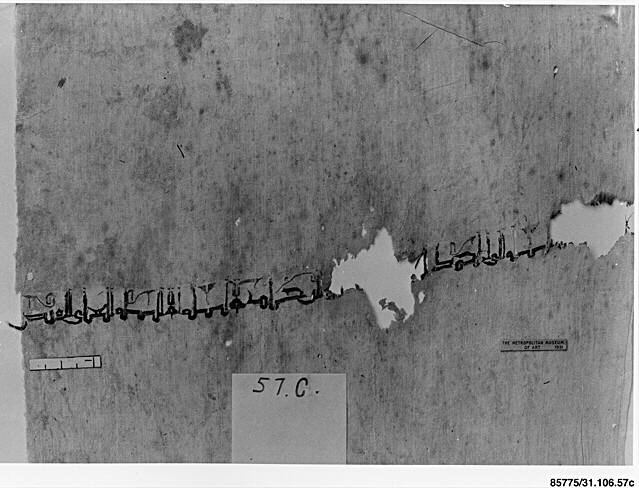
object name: textile fragment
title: Tiraz Textile Fragment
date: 1020-1035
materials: linen, silk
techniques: weave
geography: egypt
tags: arabic